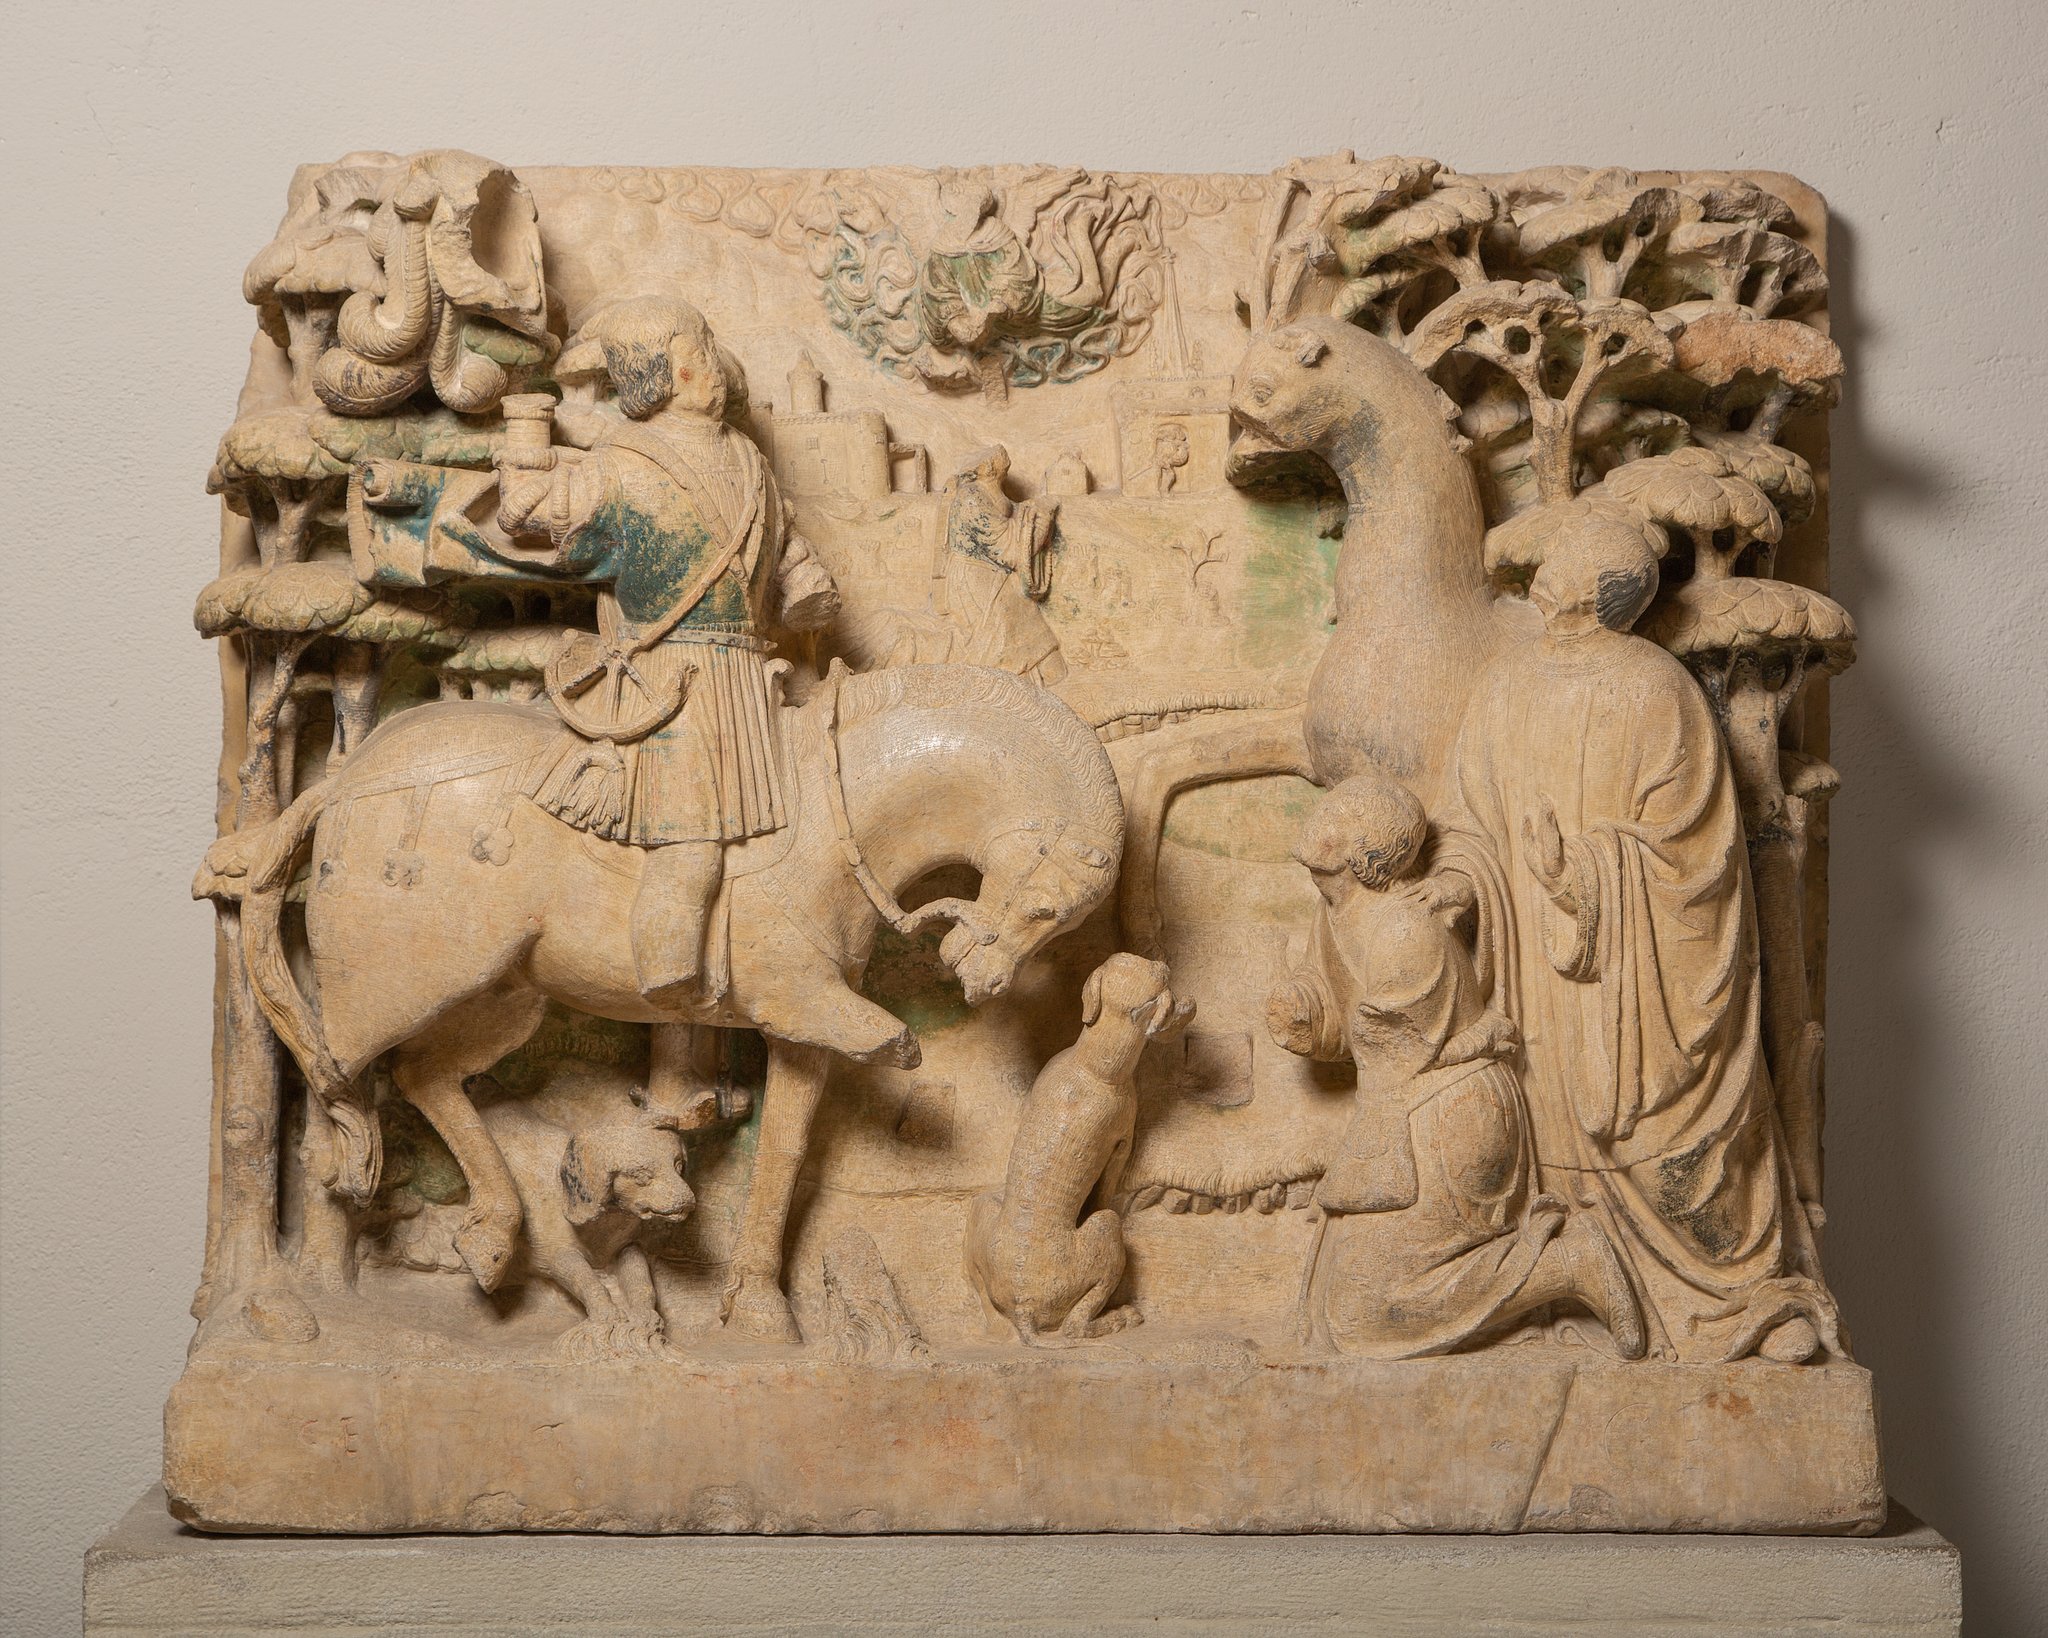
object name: relief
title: Saint Hubert and the Stag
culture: french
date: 1501-1533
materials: limestone, paint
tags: men,deer,dogs,horses,saints